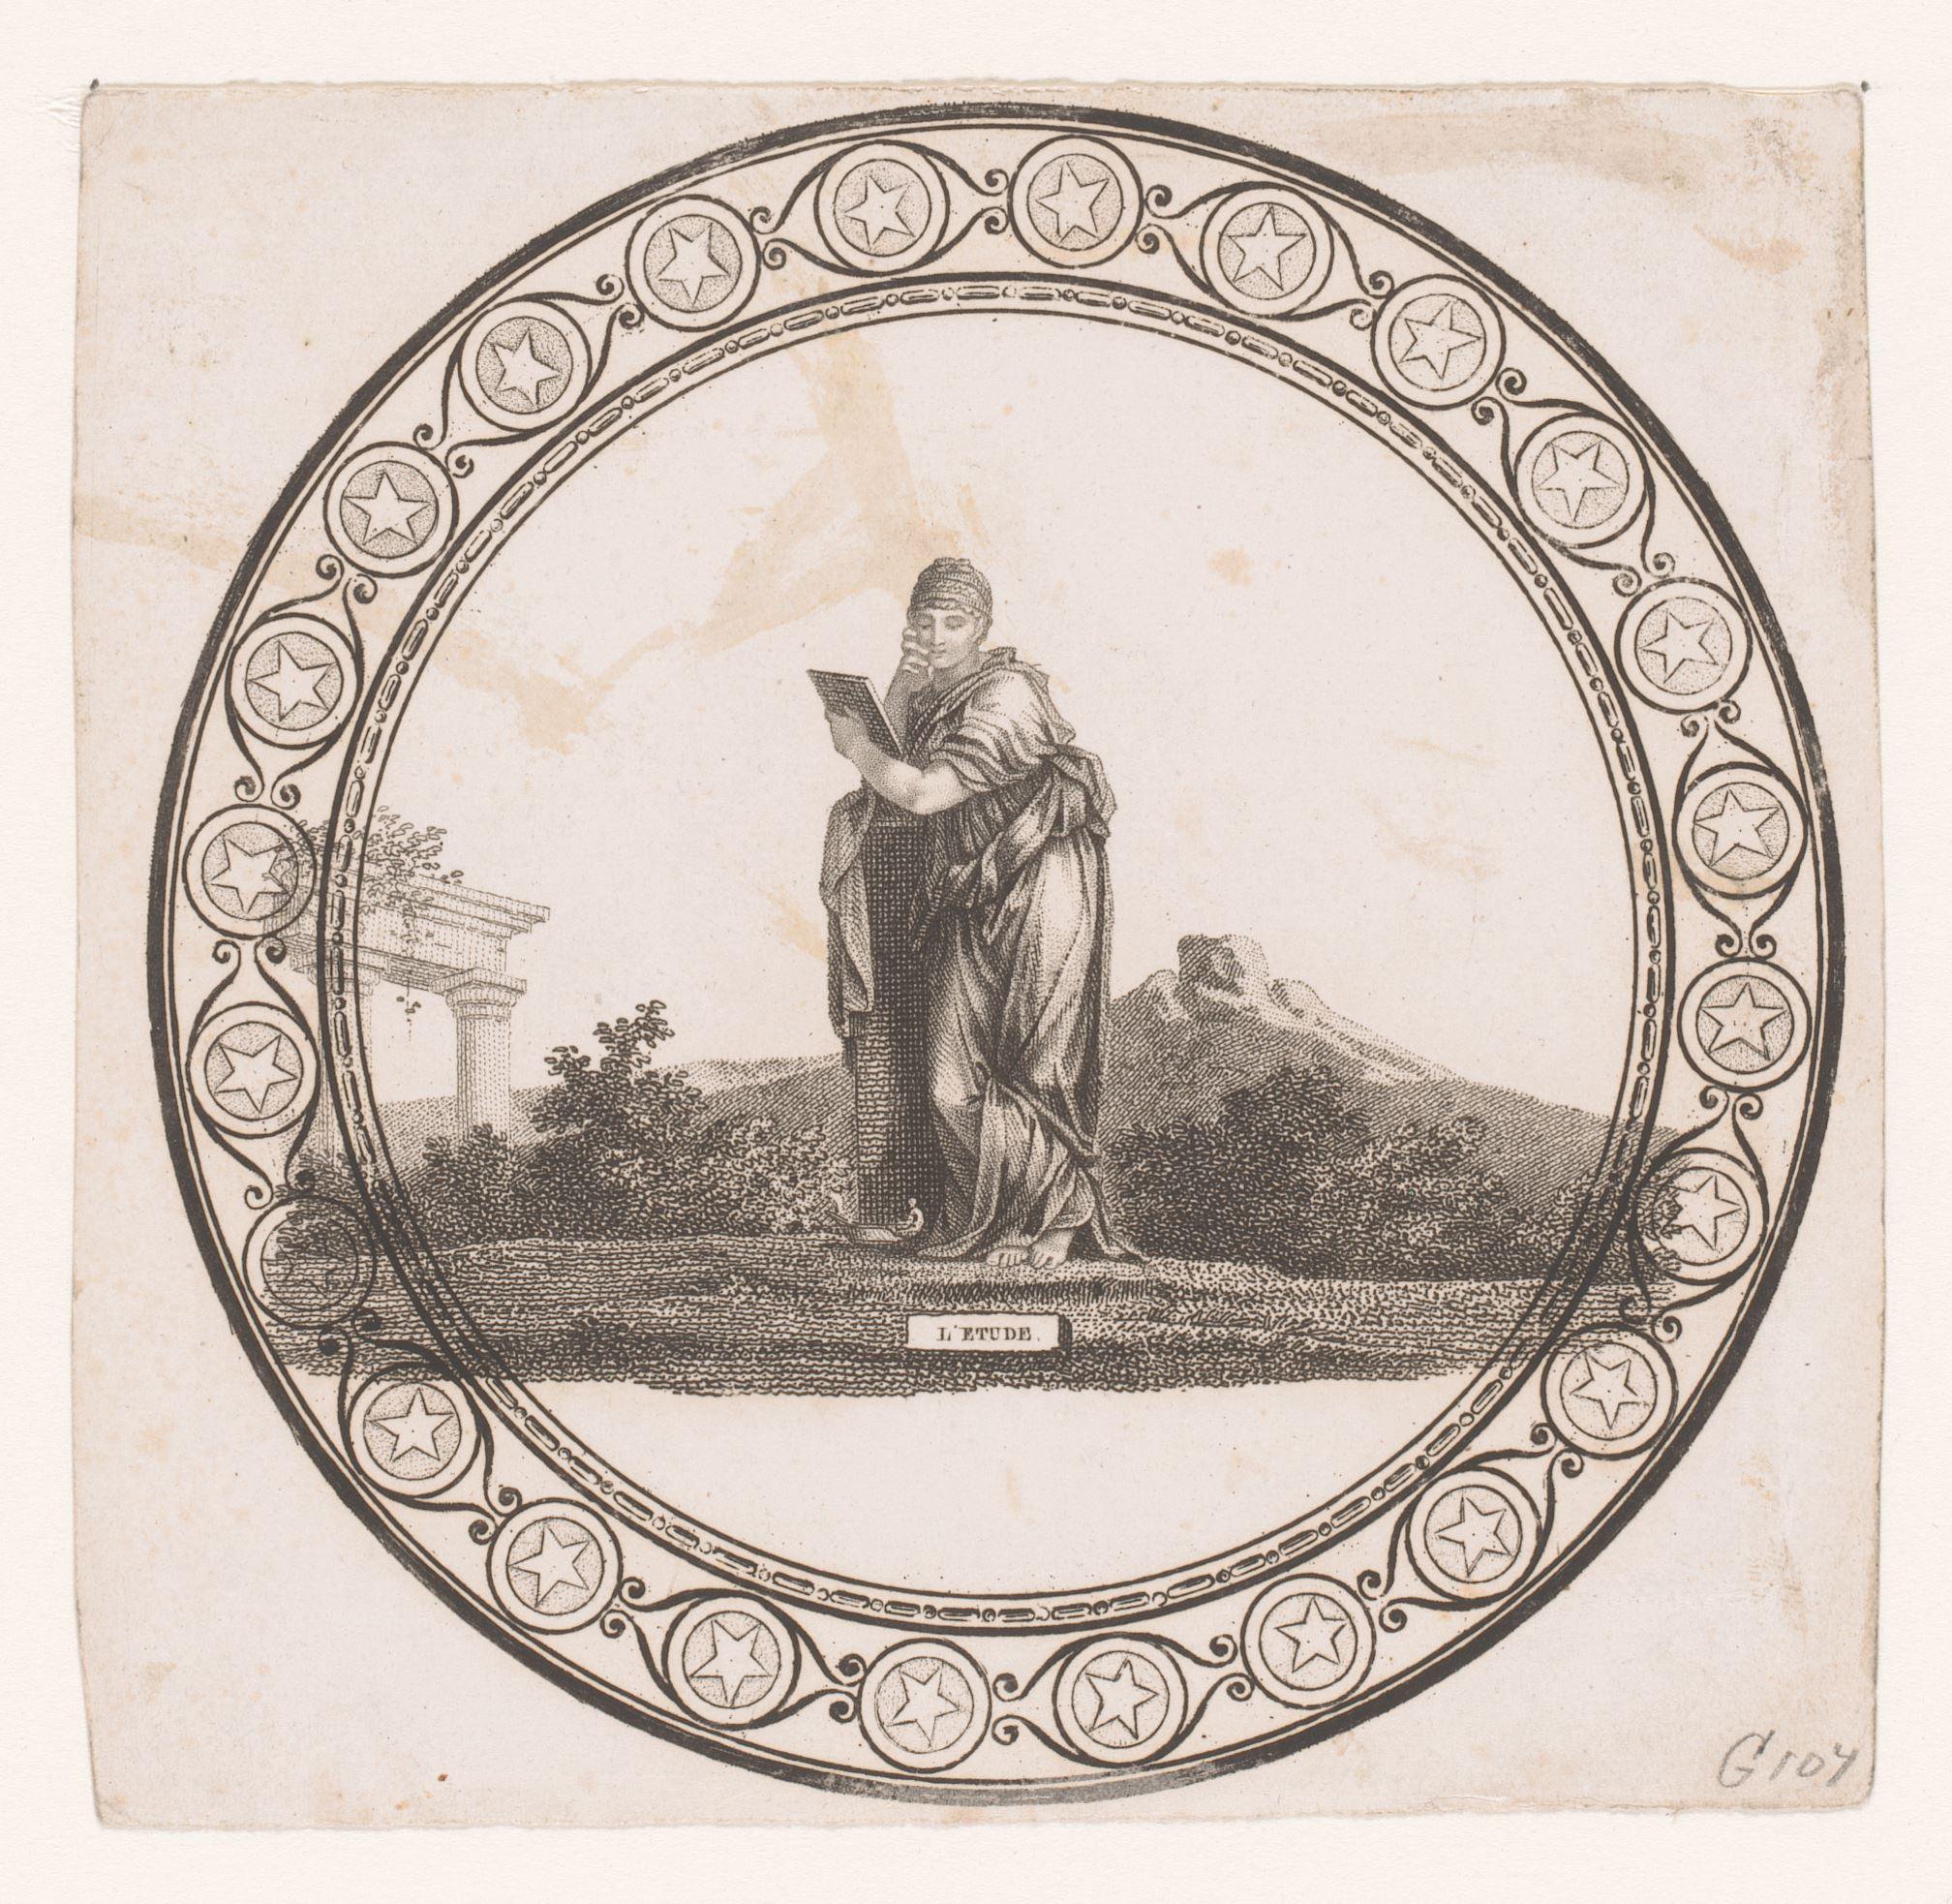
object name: print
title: Decoraties voor het stadhuis tijdens het huwelijk van Napoleon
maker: Anonymous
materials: paper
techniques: etching, roulette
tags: ornament ~ starforms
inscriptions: collector's mark: Lugt 2228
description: Bewerkte versie van een plaat uit een serie naar de figuren die als decoratie gebruikt zijn in het stadhuis, tijdens het huwelijk van Napoleon I Bonaparte en Marie Louise van Oostenrijk in 1810.